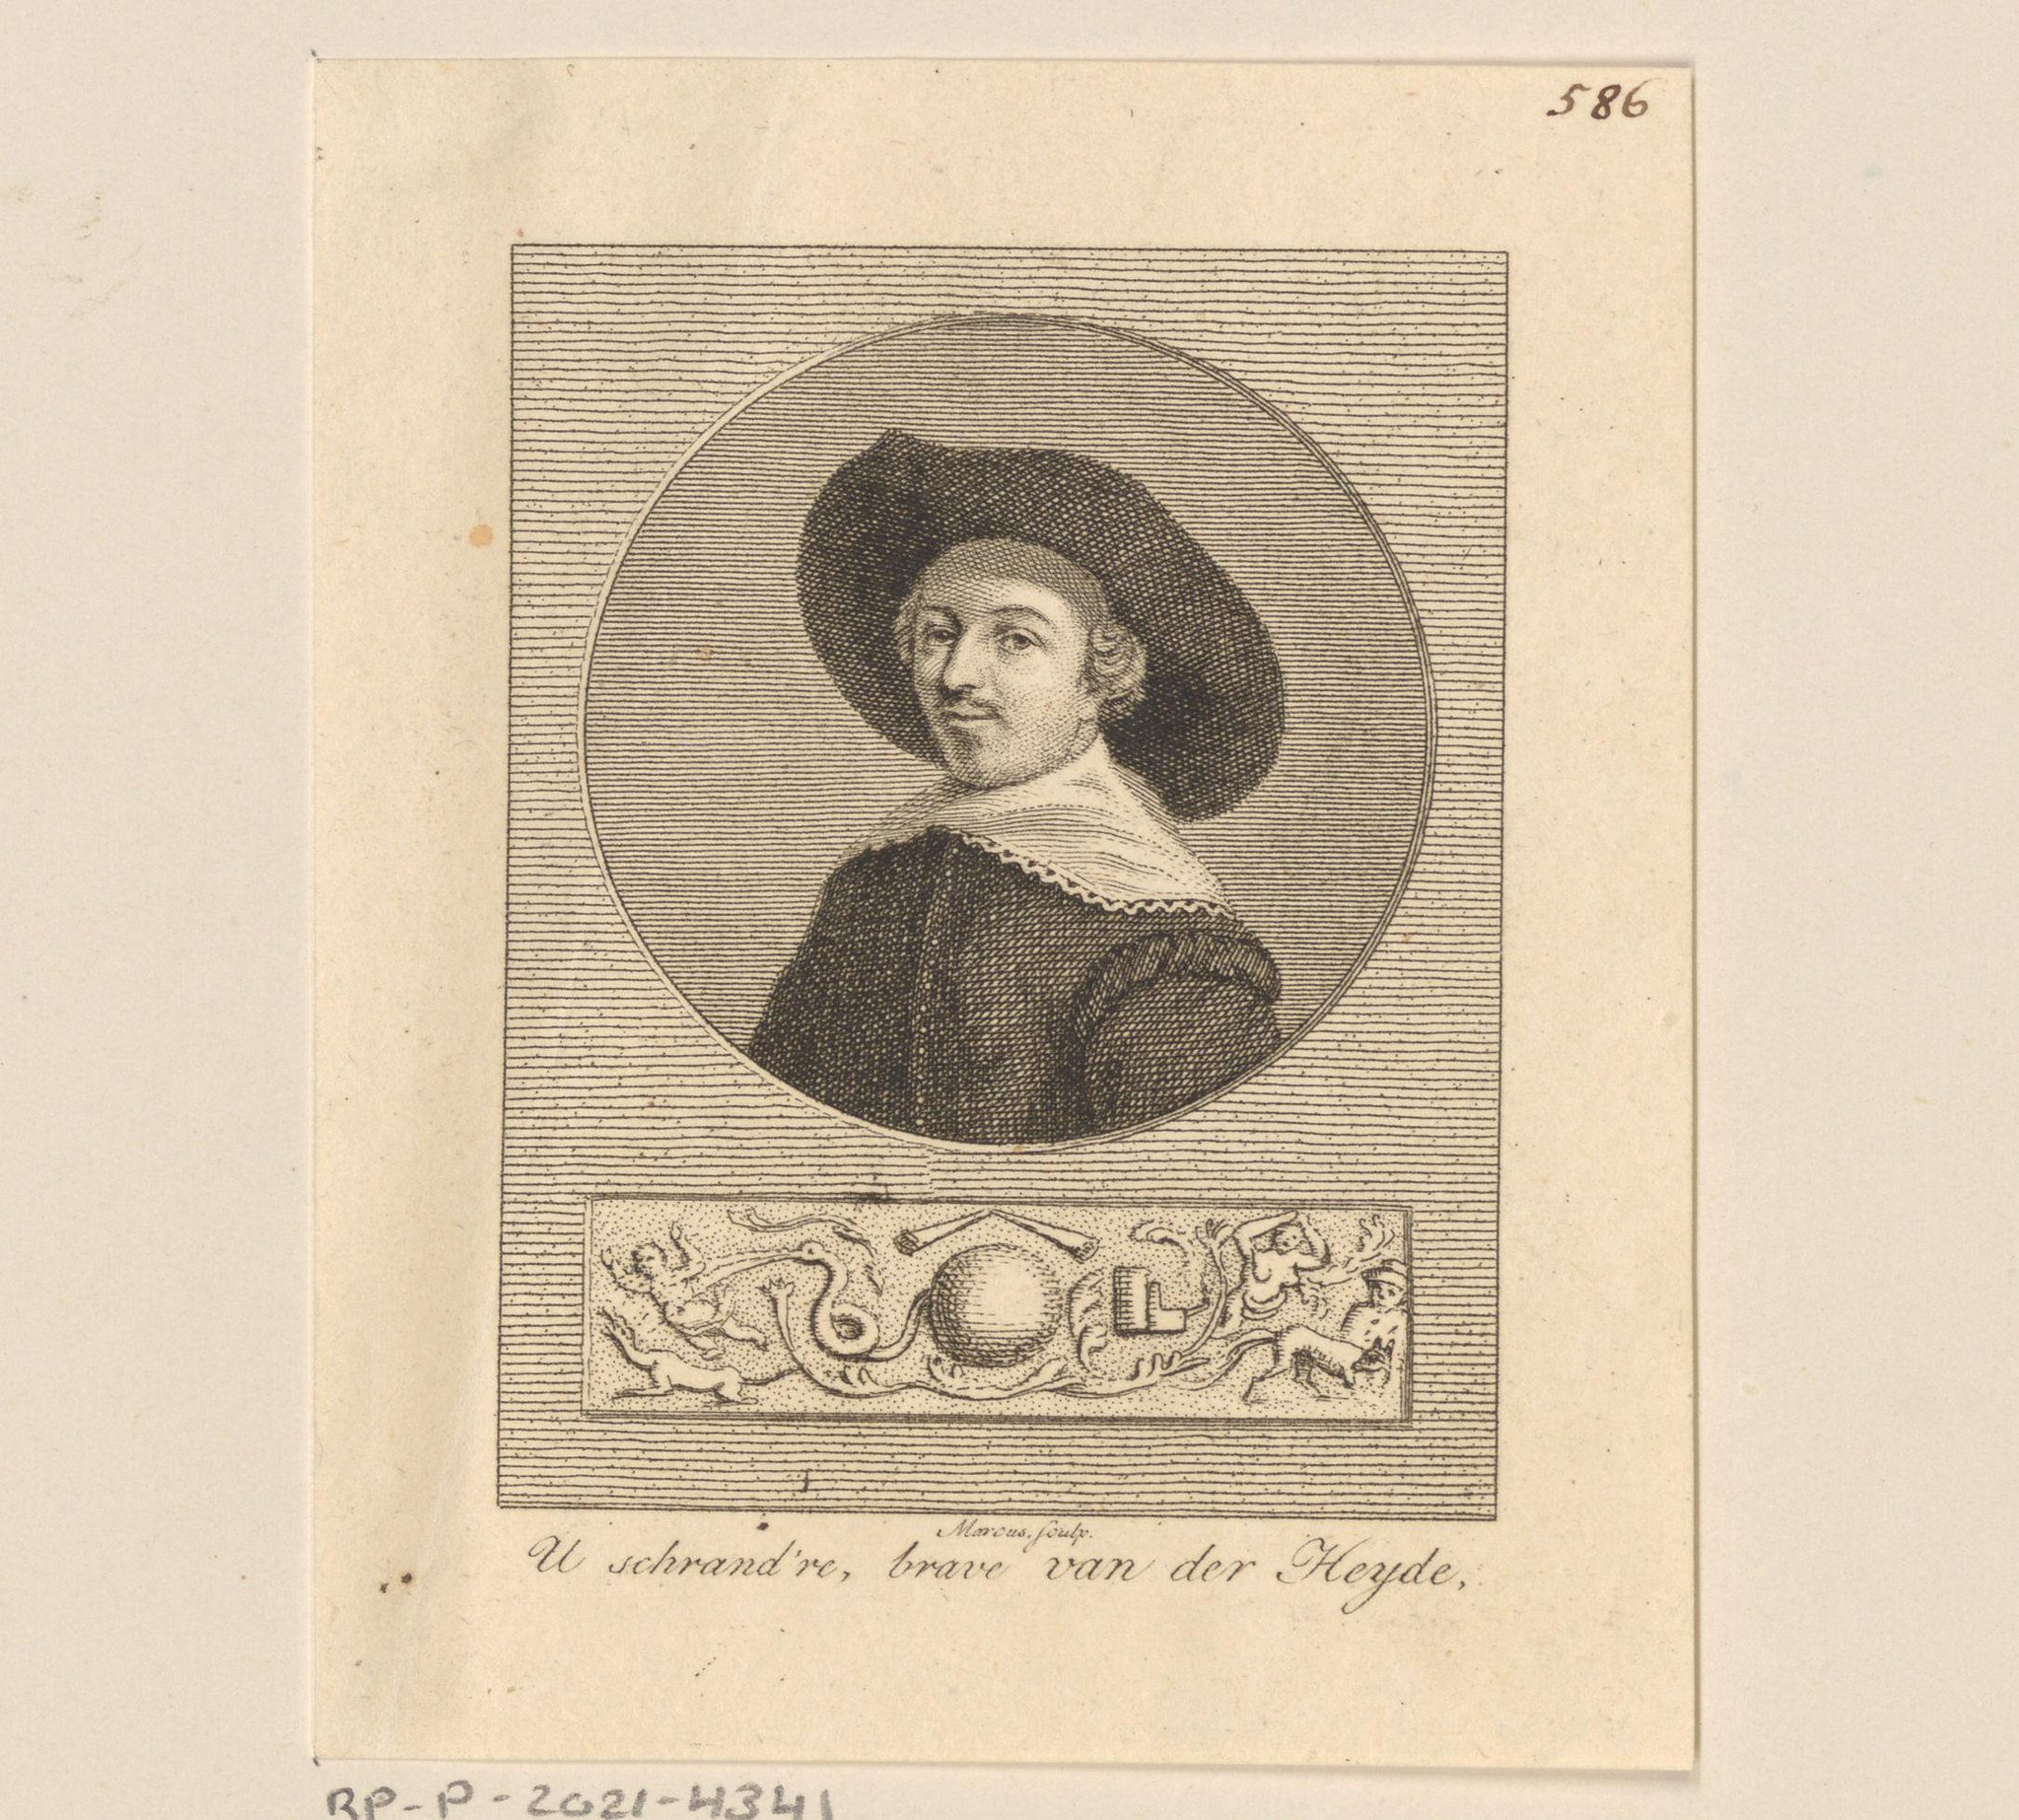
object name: print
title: Portret van Jan van der Heyden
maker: jacob ernst marcus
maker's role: draughtsman, print maker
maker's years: 1774-1826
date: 1784-1826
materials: paper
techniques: engraving, etching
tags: painter, print maker, draughtsman, jan van der heyden, historical persons, portrait, self-portrait of painter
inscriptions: number: ‘586’